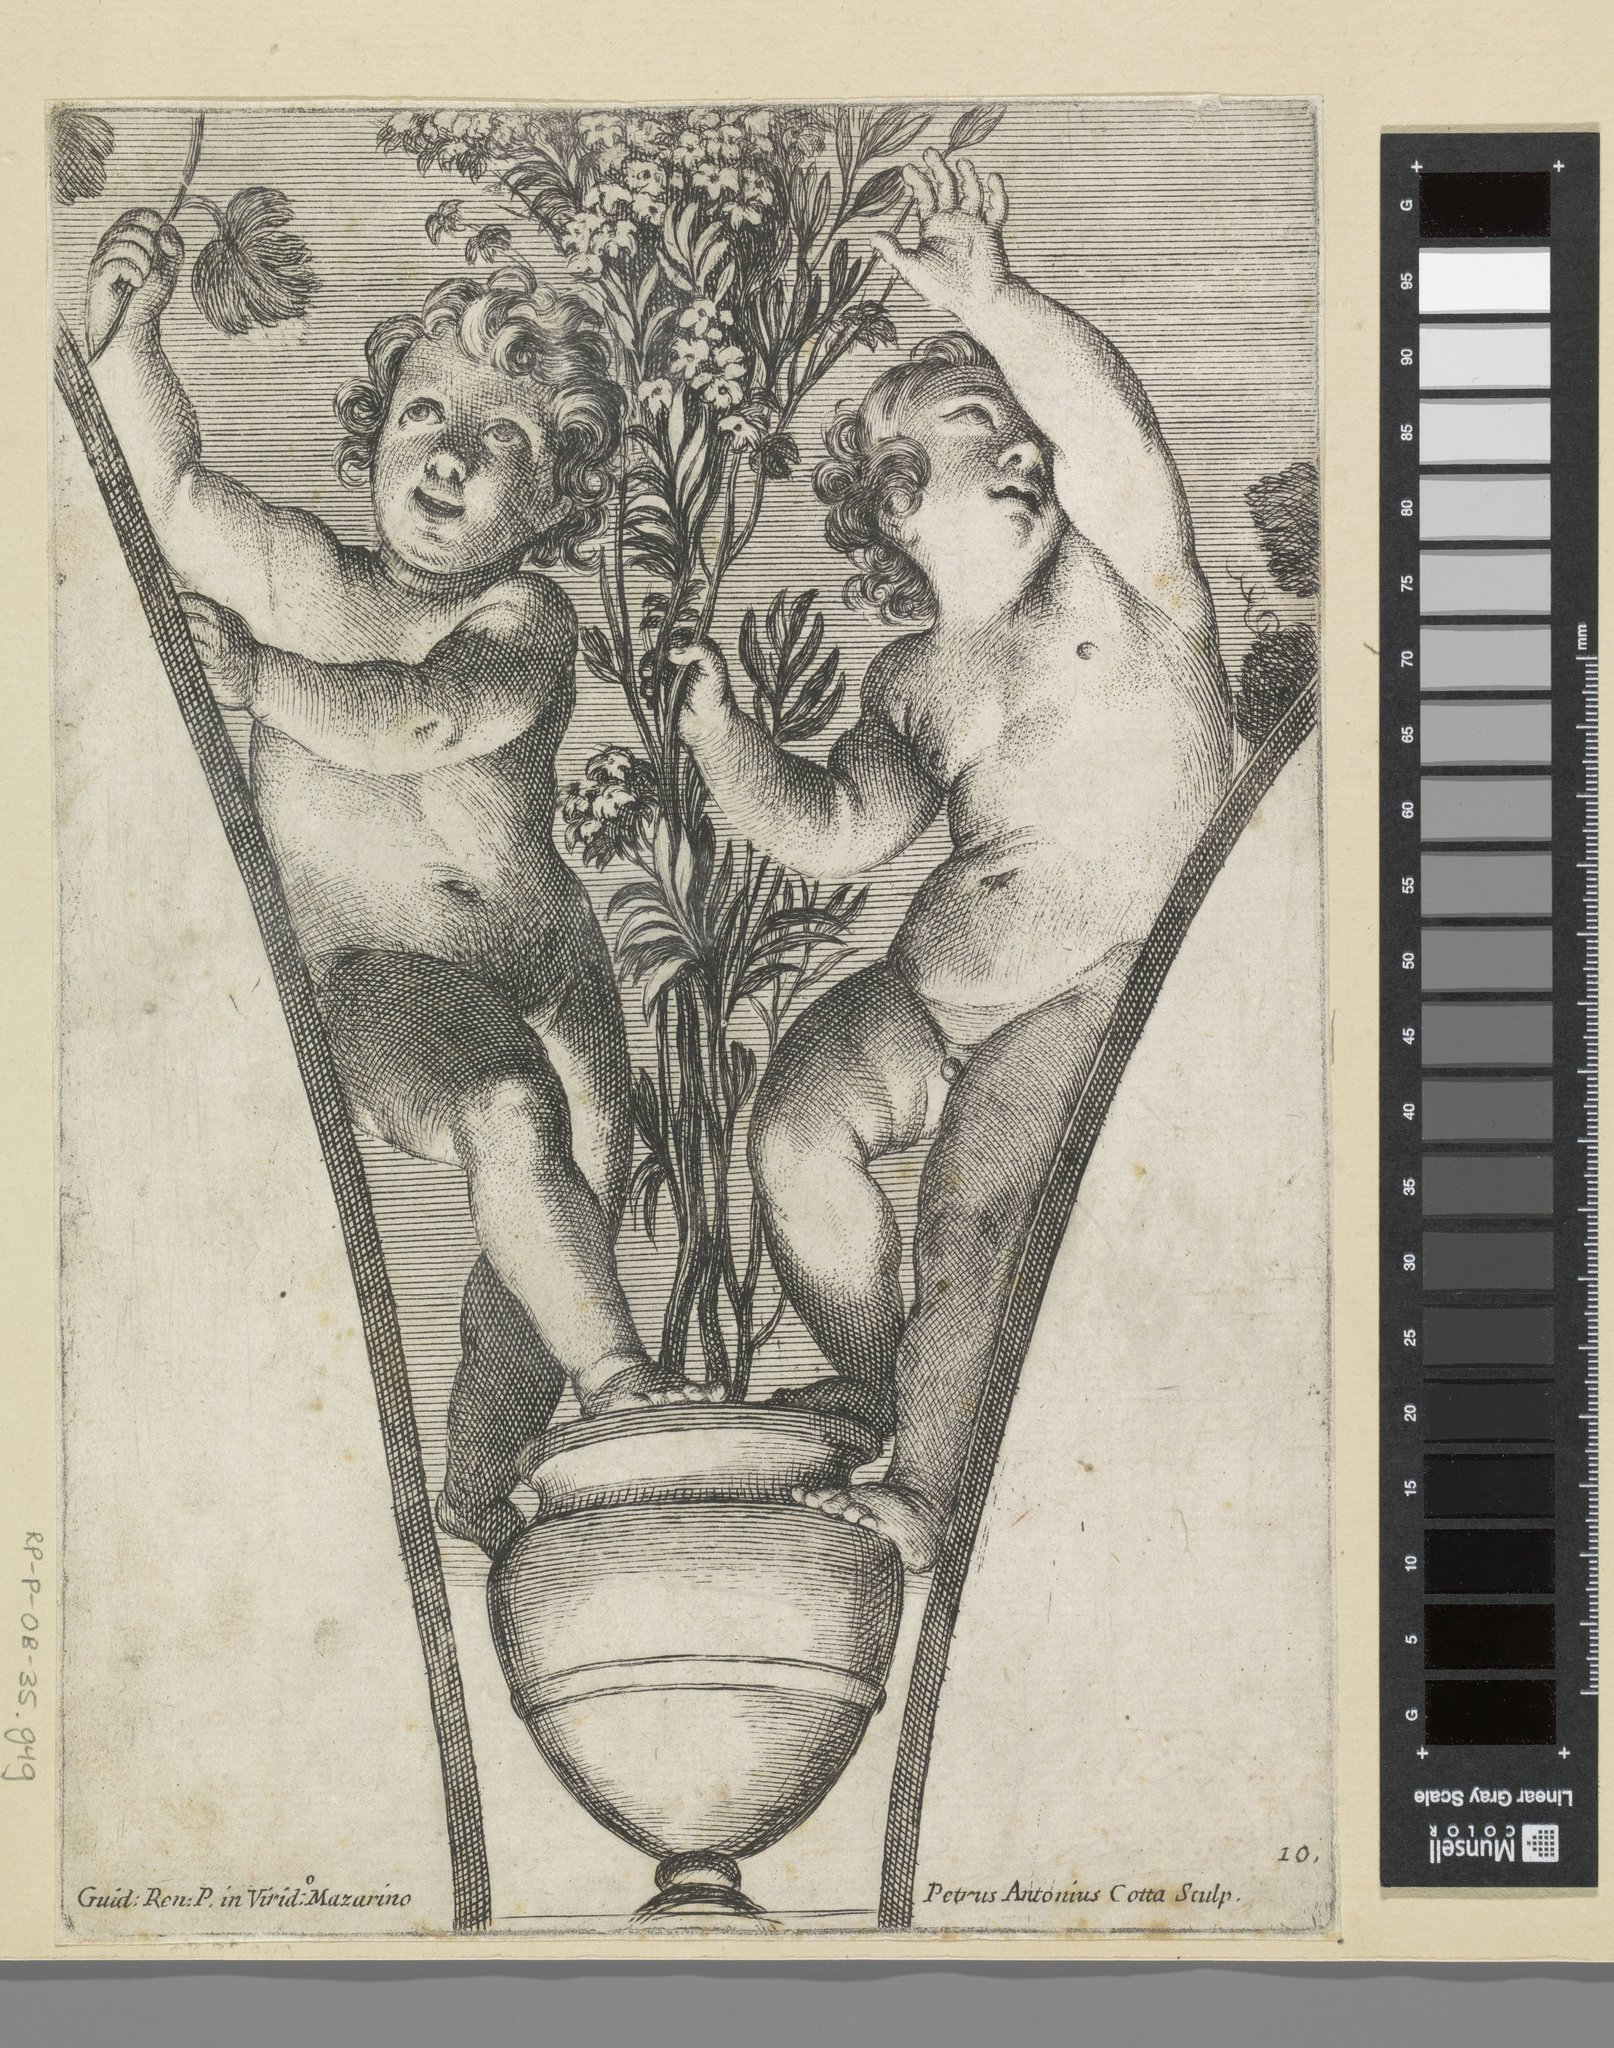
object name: print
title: Guido Reni's fresco's in de loggia van het Palazzo Rospigliosi Pallavicini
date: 1675-1685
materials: paper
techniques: etching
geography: italy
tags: cupids: 'amores', 'amoretti', 'putti', potted plants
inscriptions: collector's mark: Lugt 240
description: Naar fresco's door Guido Reni in de loggia van het Palazzo Rospigliosi Pallavicini.